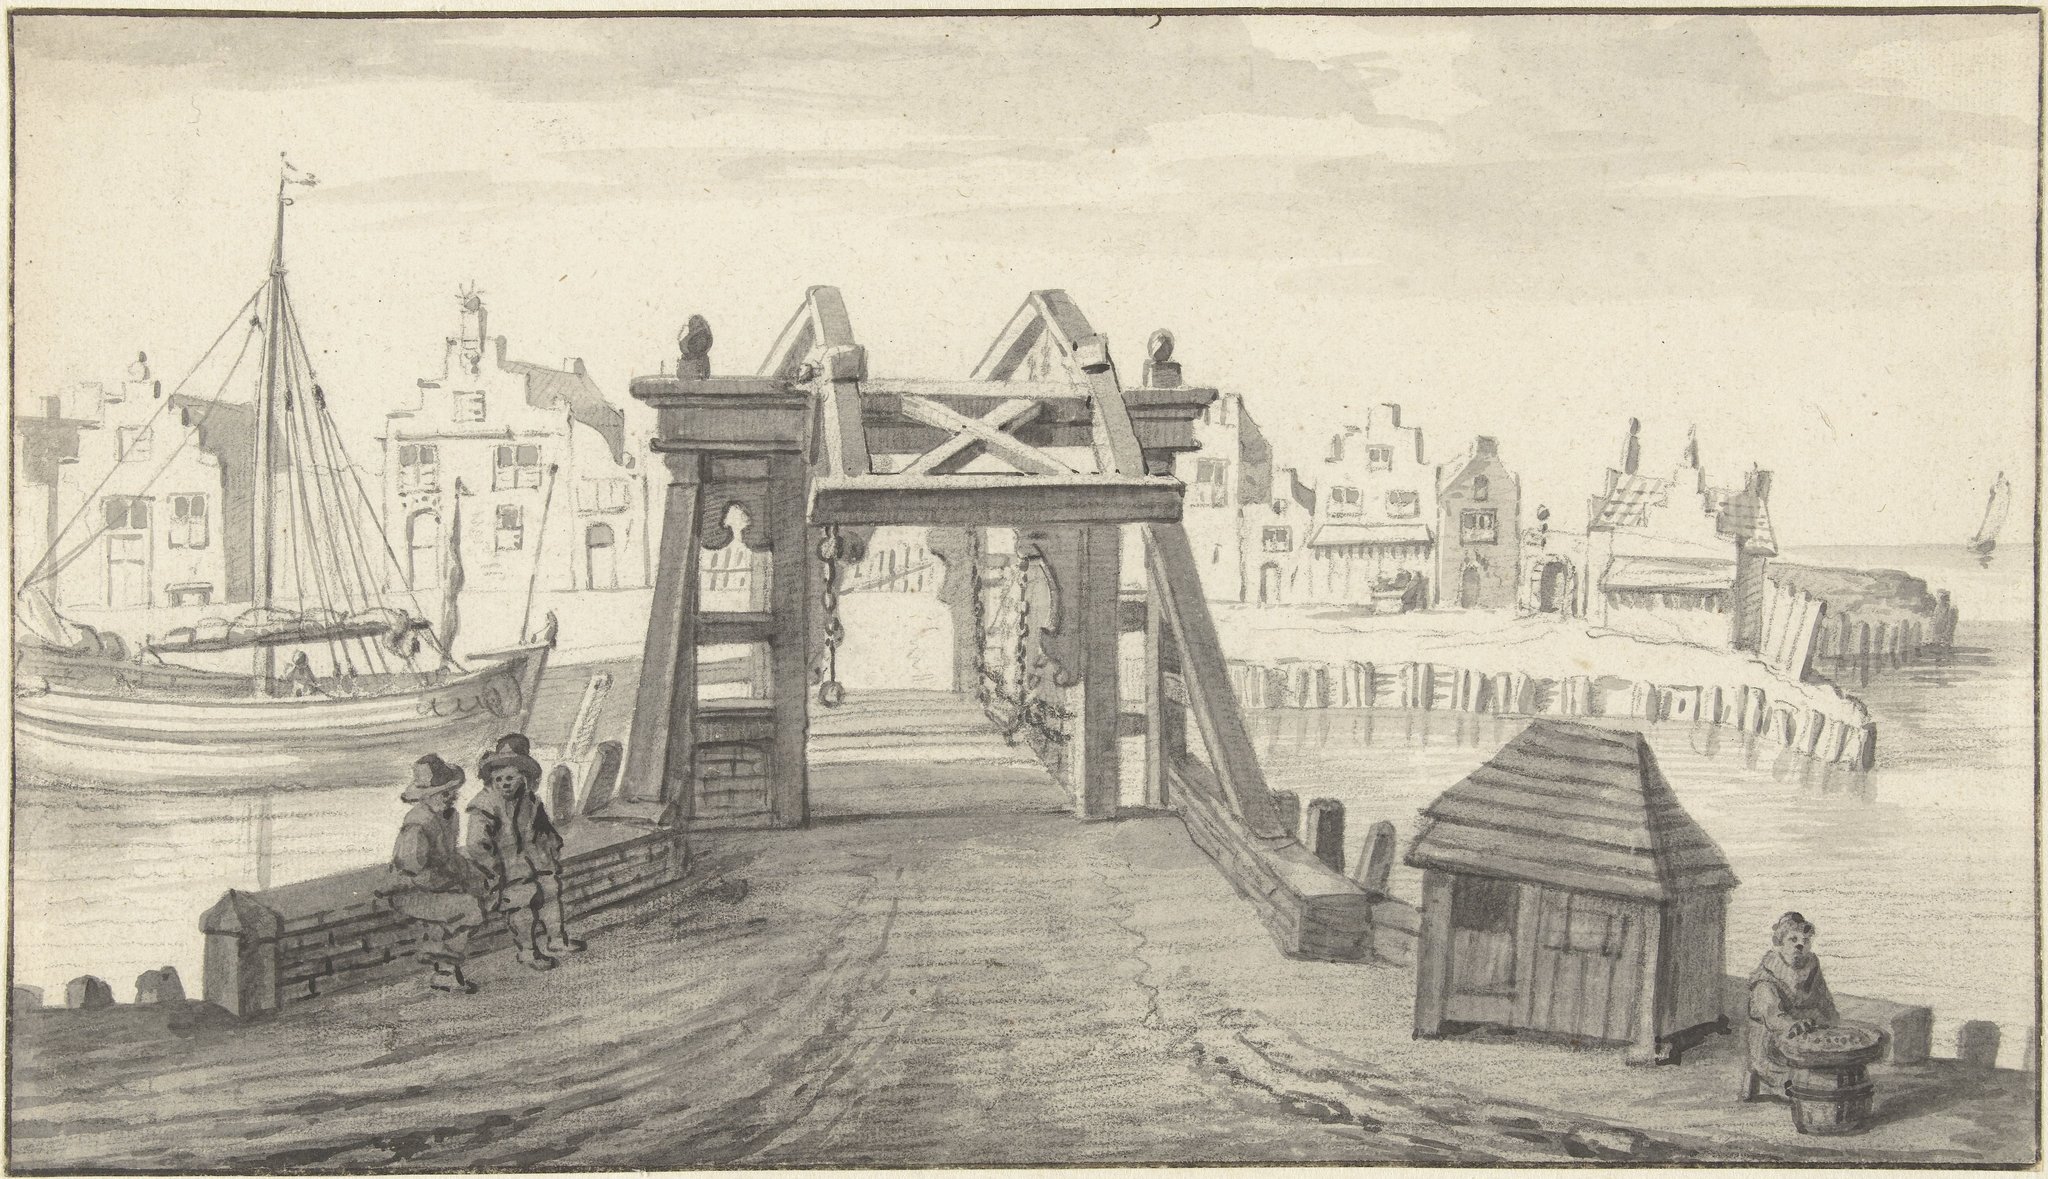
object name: drawing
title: Ophaalbrug in Brielle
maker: joseph adolf schmetterling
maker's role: draughtsman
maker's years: 1751-1828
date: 1761-1828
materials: chalk, paper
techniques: brush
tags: prospect of city, town panorama, silhouette of city, brielle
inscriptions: inscription: ‘J. A. Schmetterling delt / N. 10 / In den Briele’